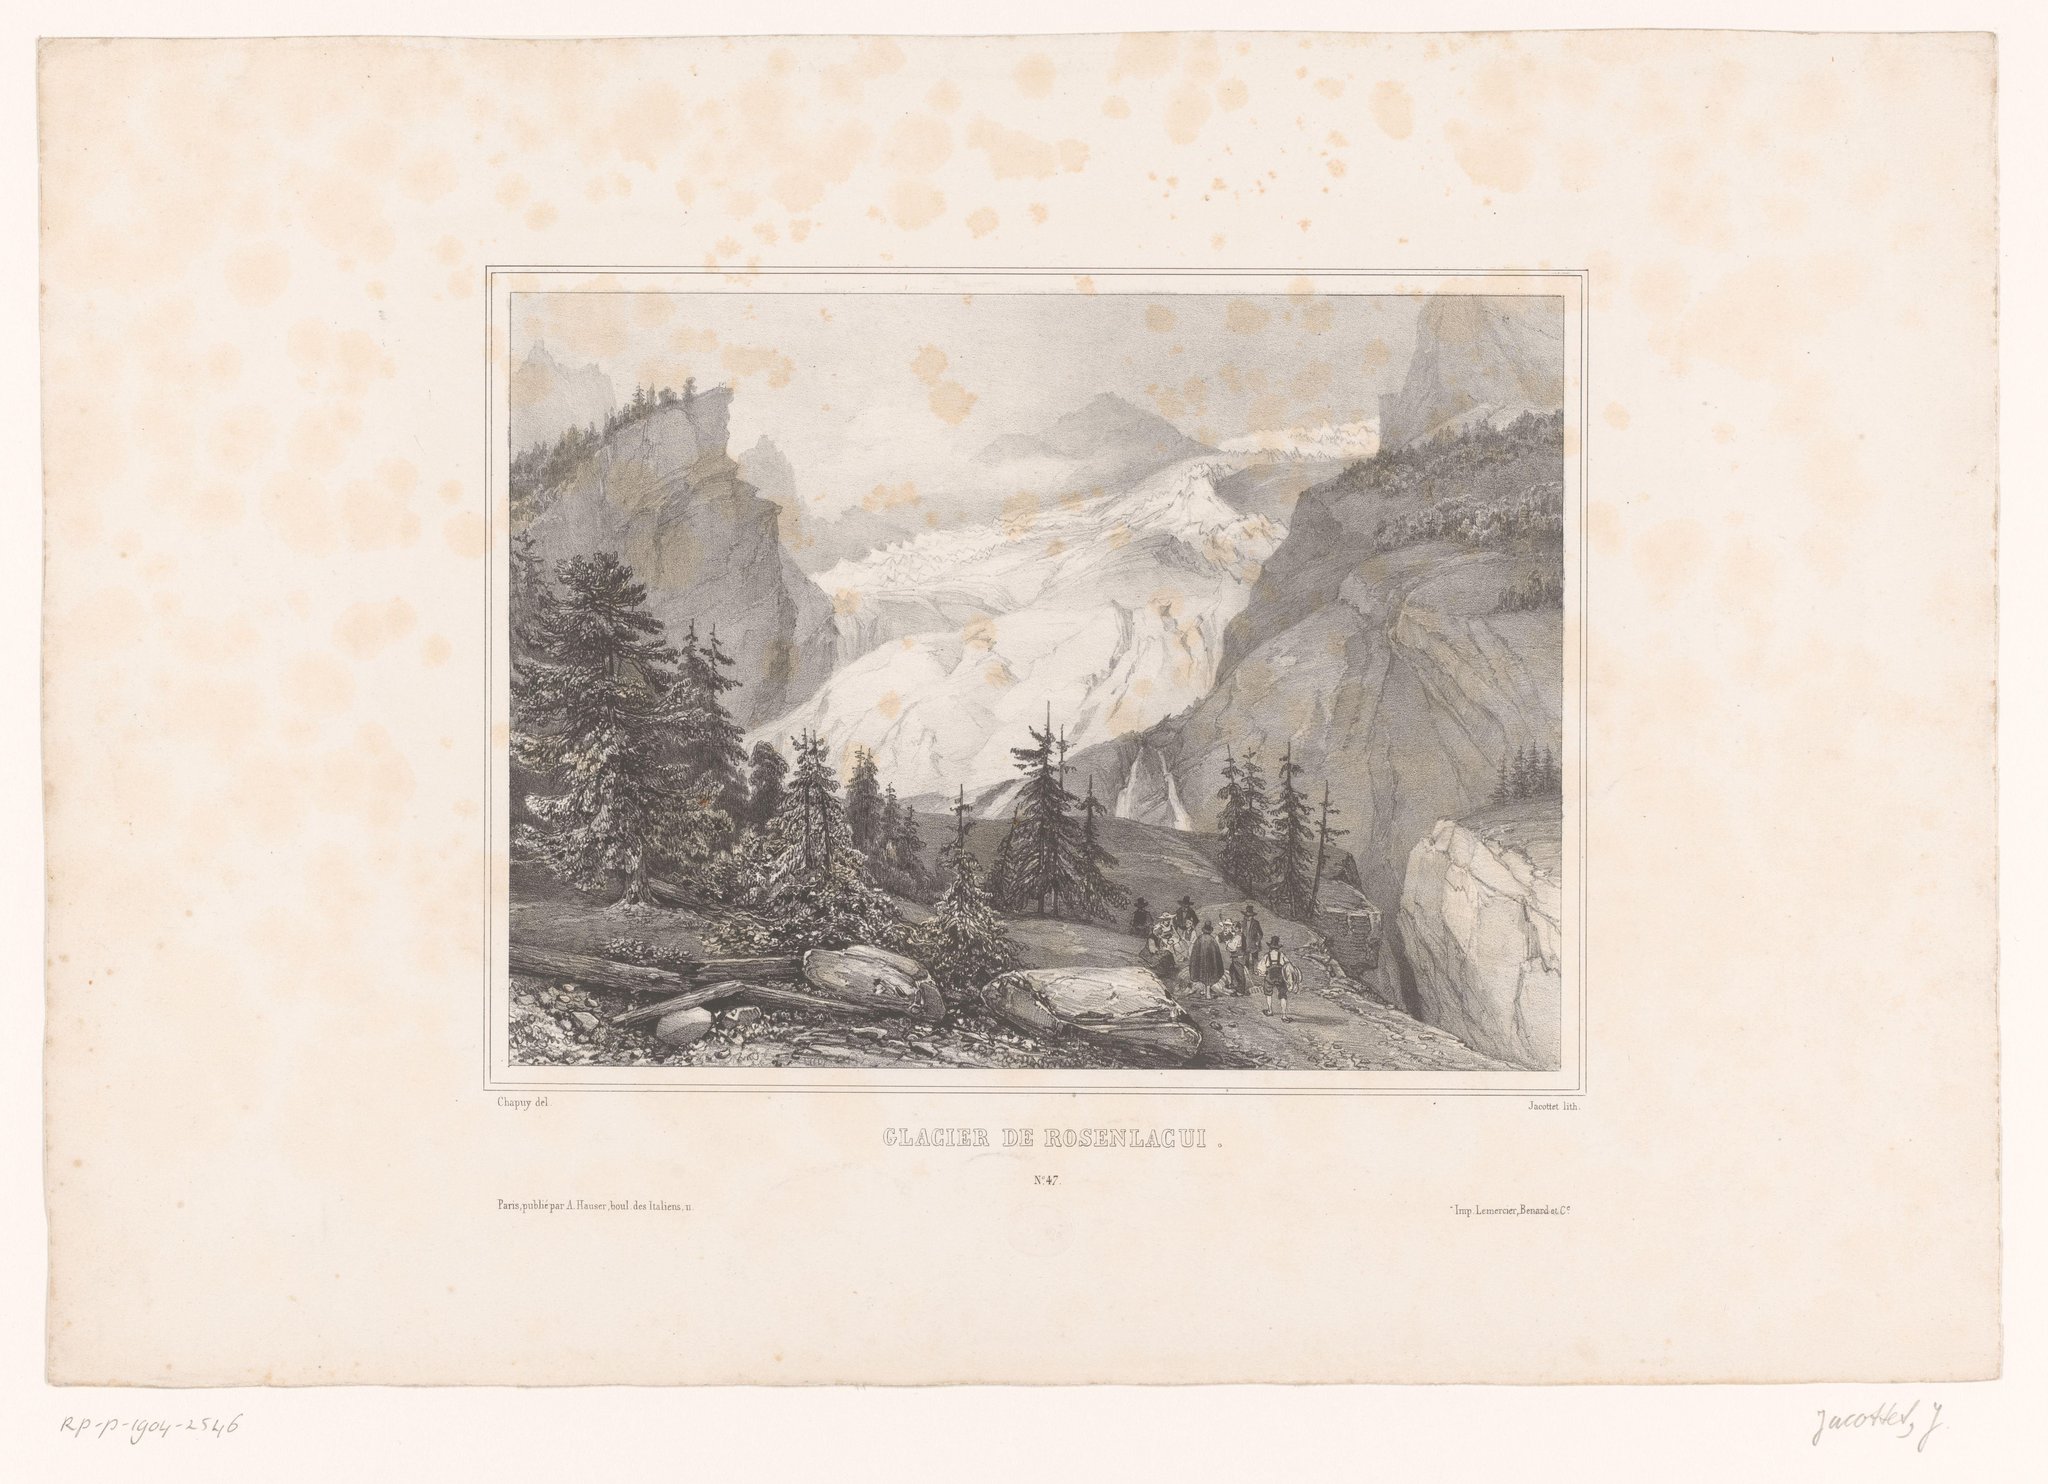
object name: print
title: Zicht op de Rosenlauigletsjer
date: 1836-1840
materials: paper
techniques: lithograph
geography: paris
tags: glacier (+ landscape with figures, staffage)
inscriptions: collector's mark: Lugt 2228a, check stamp: Lugt 4619